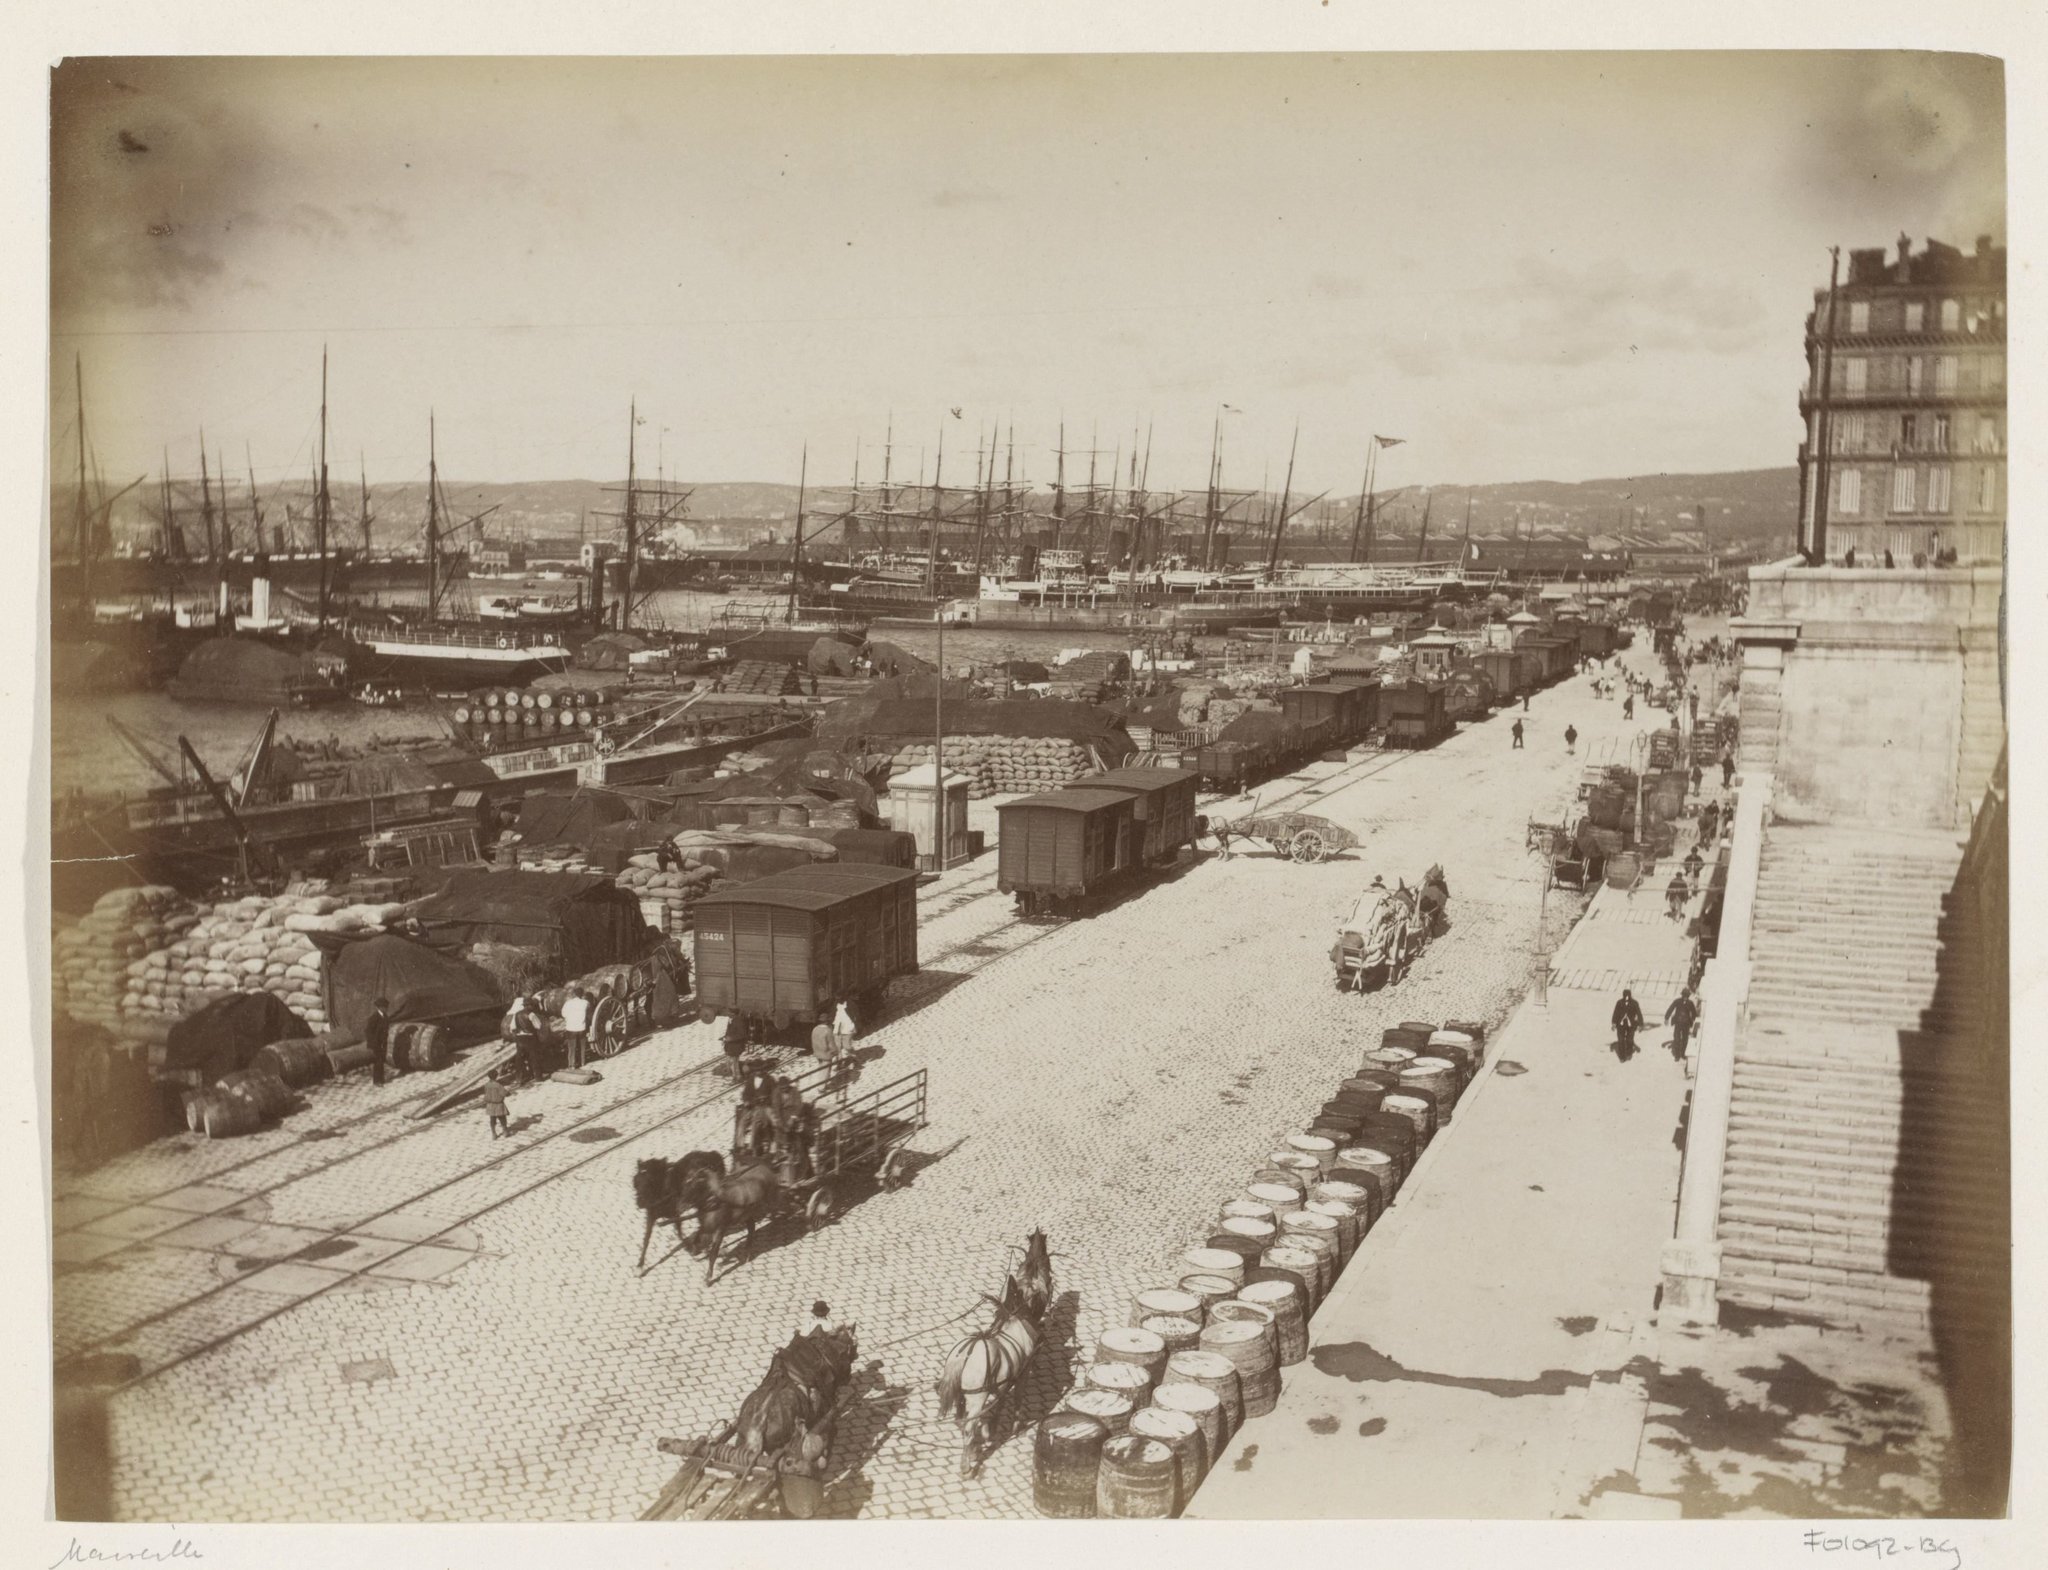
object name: photograph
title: Gezicht op schepen en goederenoverslag in de haven van Marseille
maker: Anonymous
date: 1880-1900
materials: cardboard, paper, photographic support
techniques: albumen print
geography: marseille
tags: harbour (+ view ~ vehicle, ship, etc.), railway, train, quay (+ city(-scape) with figures, staffage), marseille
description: Onderdeel van Reisalbum met foto's van bezienswaardigheden in België en Frankrijk.